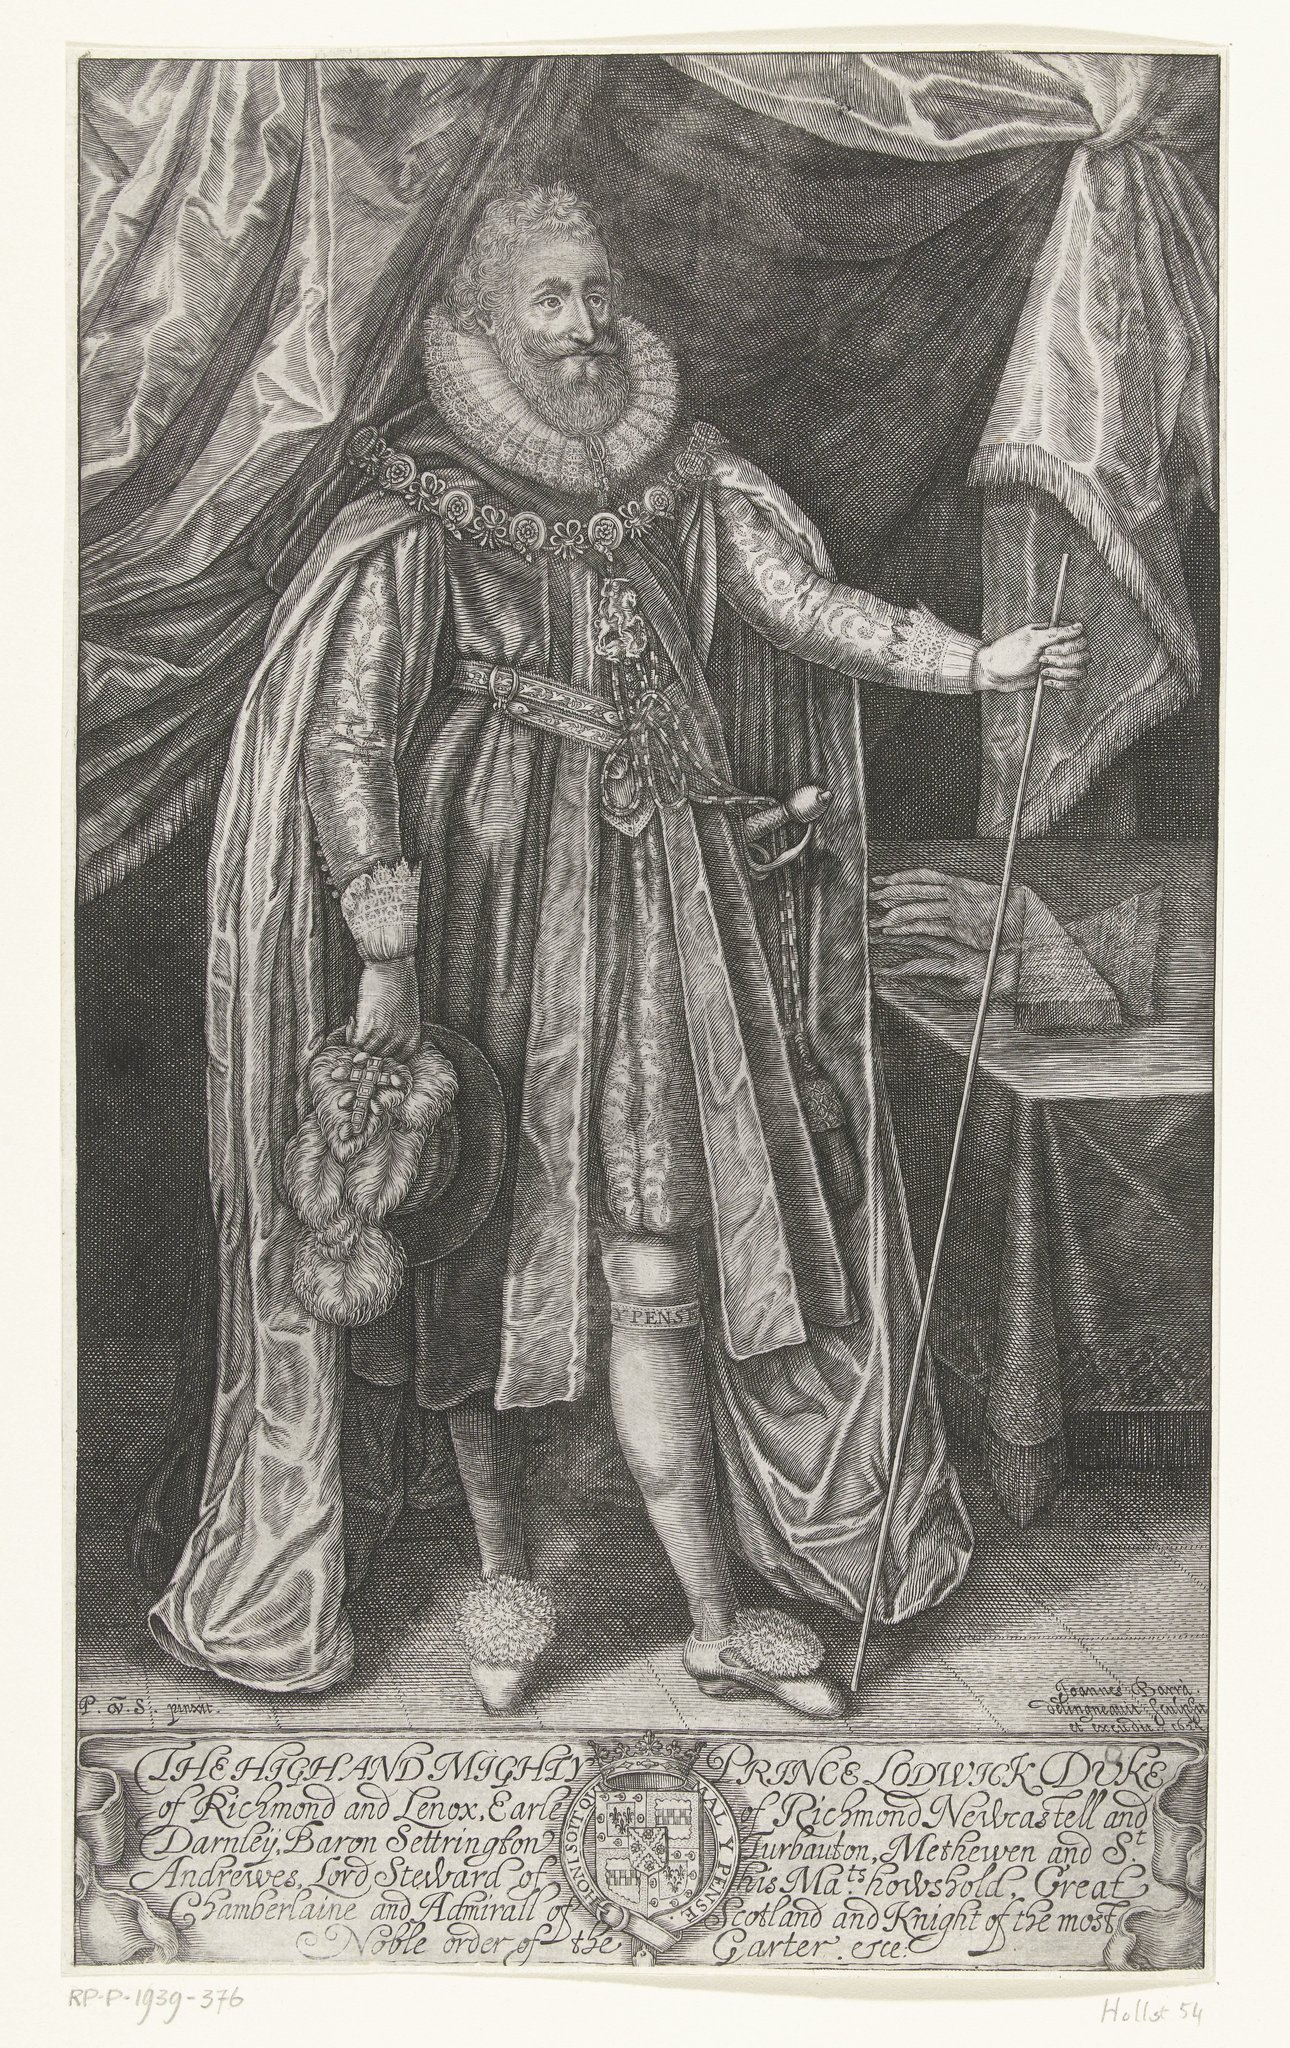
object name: print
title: Portret van Ludovic Stewart (Stuart) hertog van Richmond en Lennox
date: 1624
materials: paper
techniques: engraving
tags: politician, knighthood order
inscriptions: collector's mark: Lugt 151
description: Portret van Ludovic Stewart hertog van Richmond en Lennox (1623-'24), ten voeten uit met ketting waaraan hanger met Sint Joris en de draak. Om zijn been een kousenband waarop een gedeelte van zijn motto leesbaar is, dit motto staat ook op een wapen onder de voorstelling: Honi soit qui mal y pense.